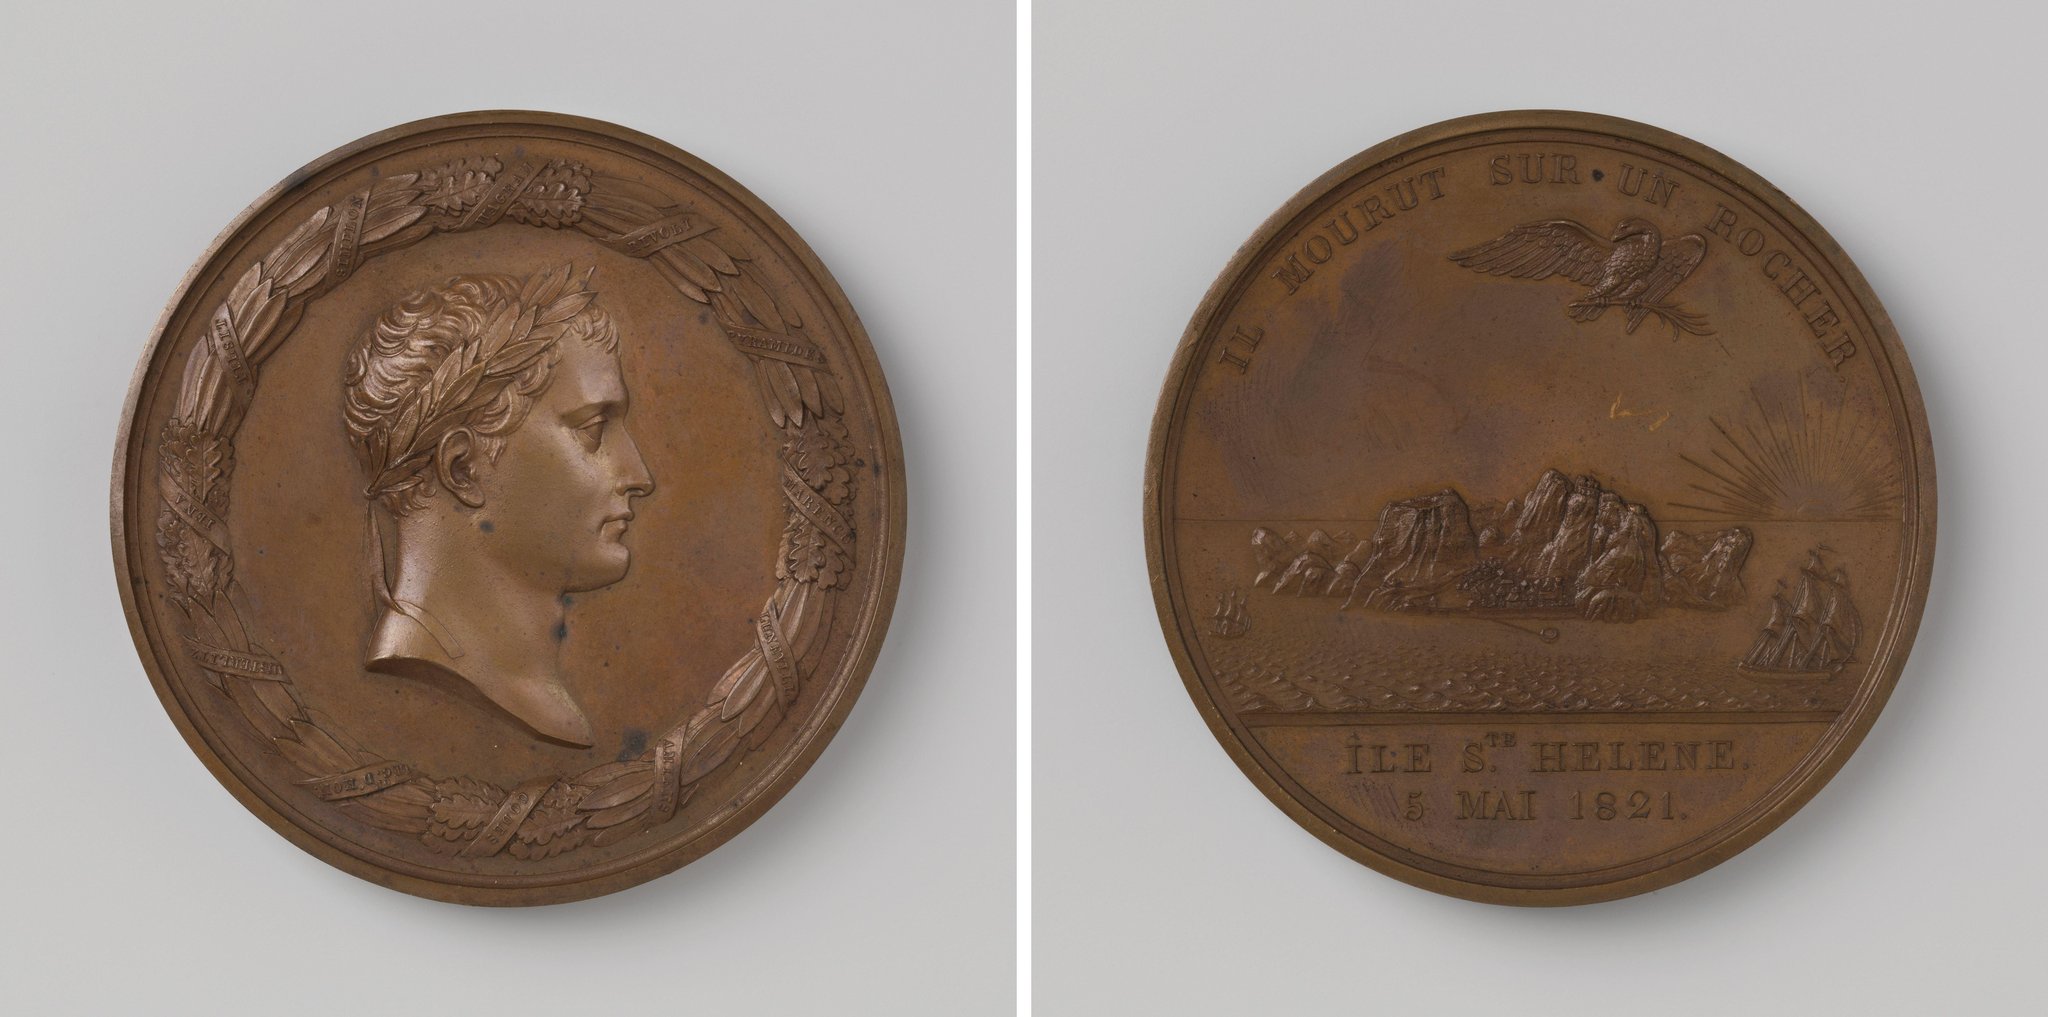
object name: history medal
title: Dood van Napoleon Bonaparte, overleden op St. Helena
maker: Anonymous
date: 1821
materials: bronze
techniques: striking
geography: france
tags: napoleon i (emperor of the french)